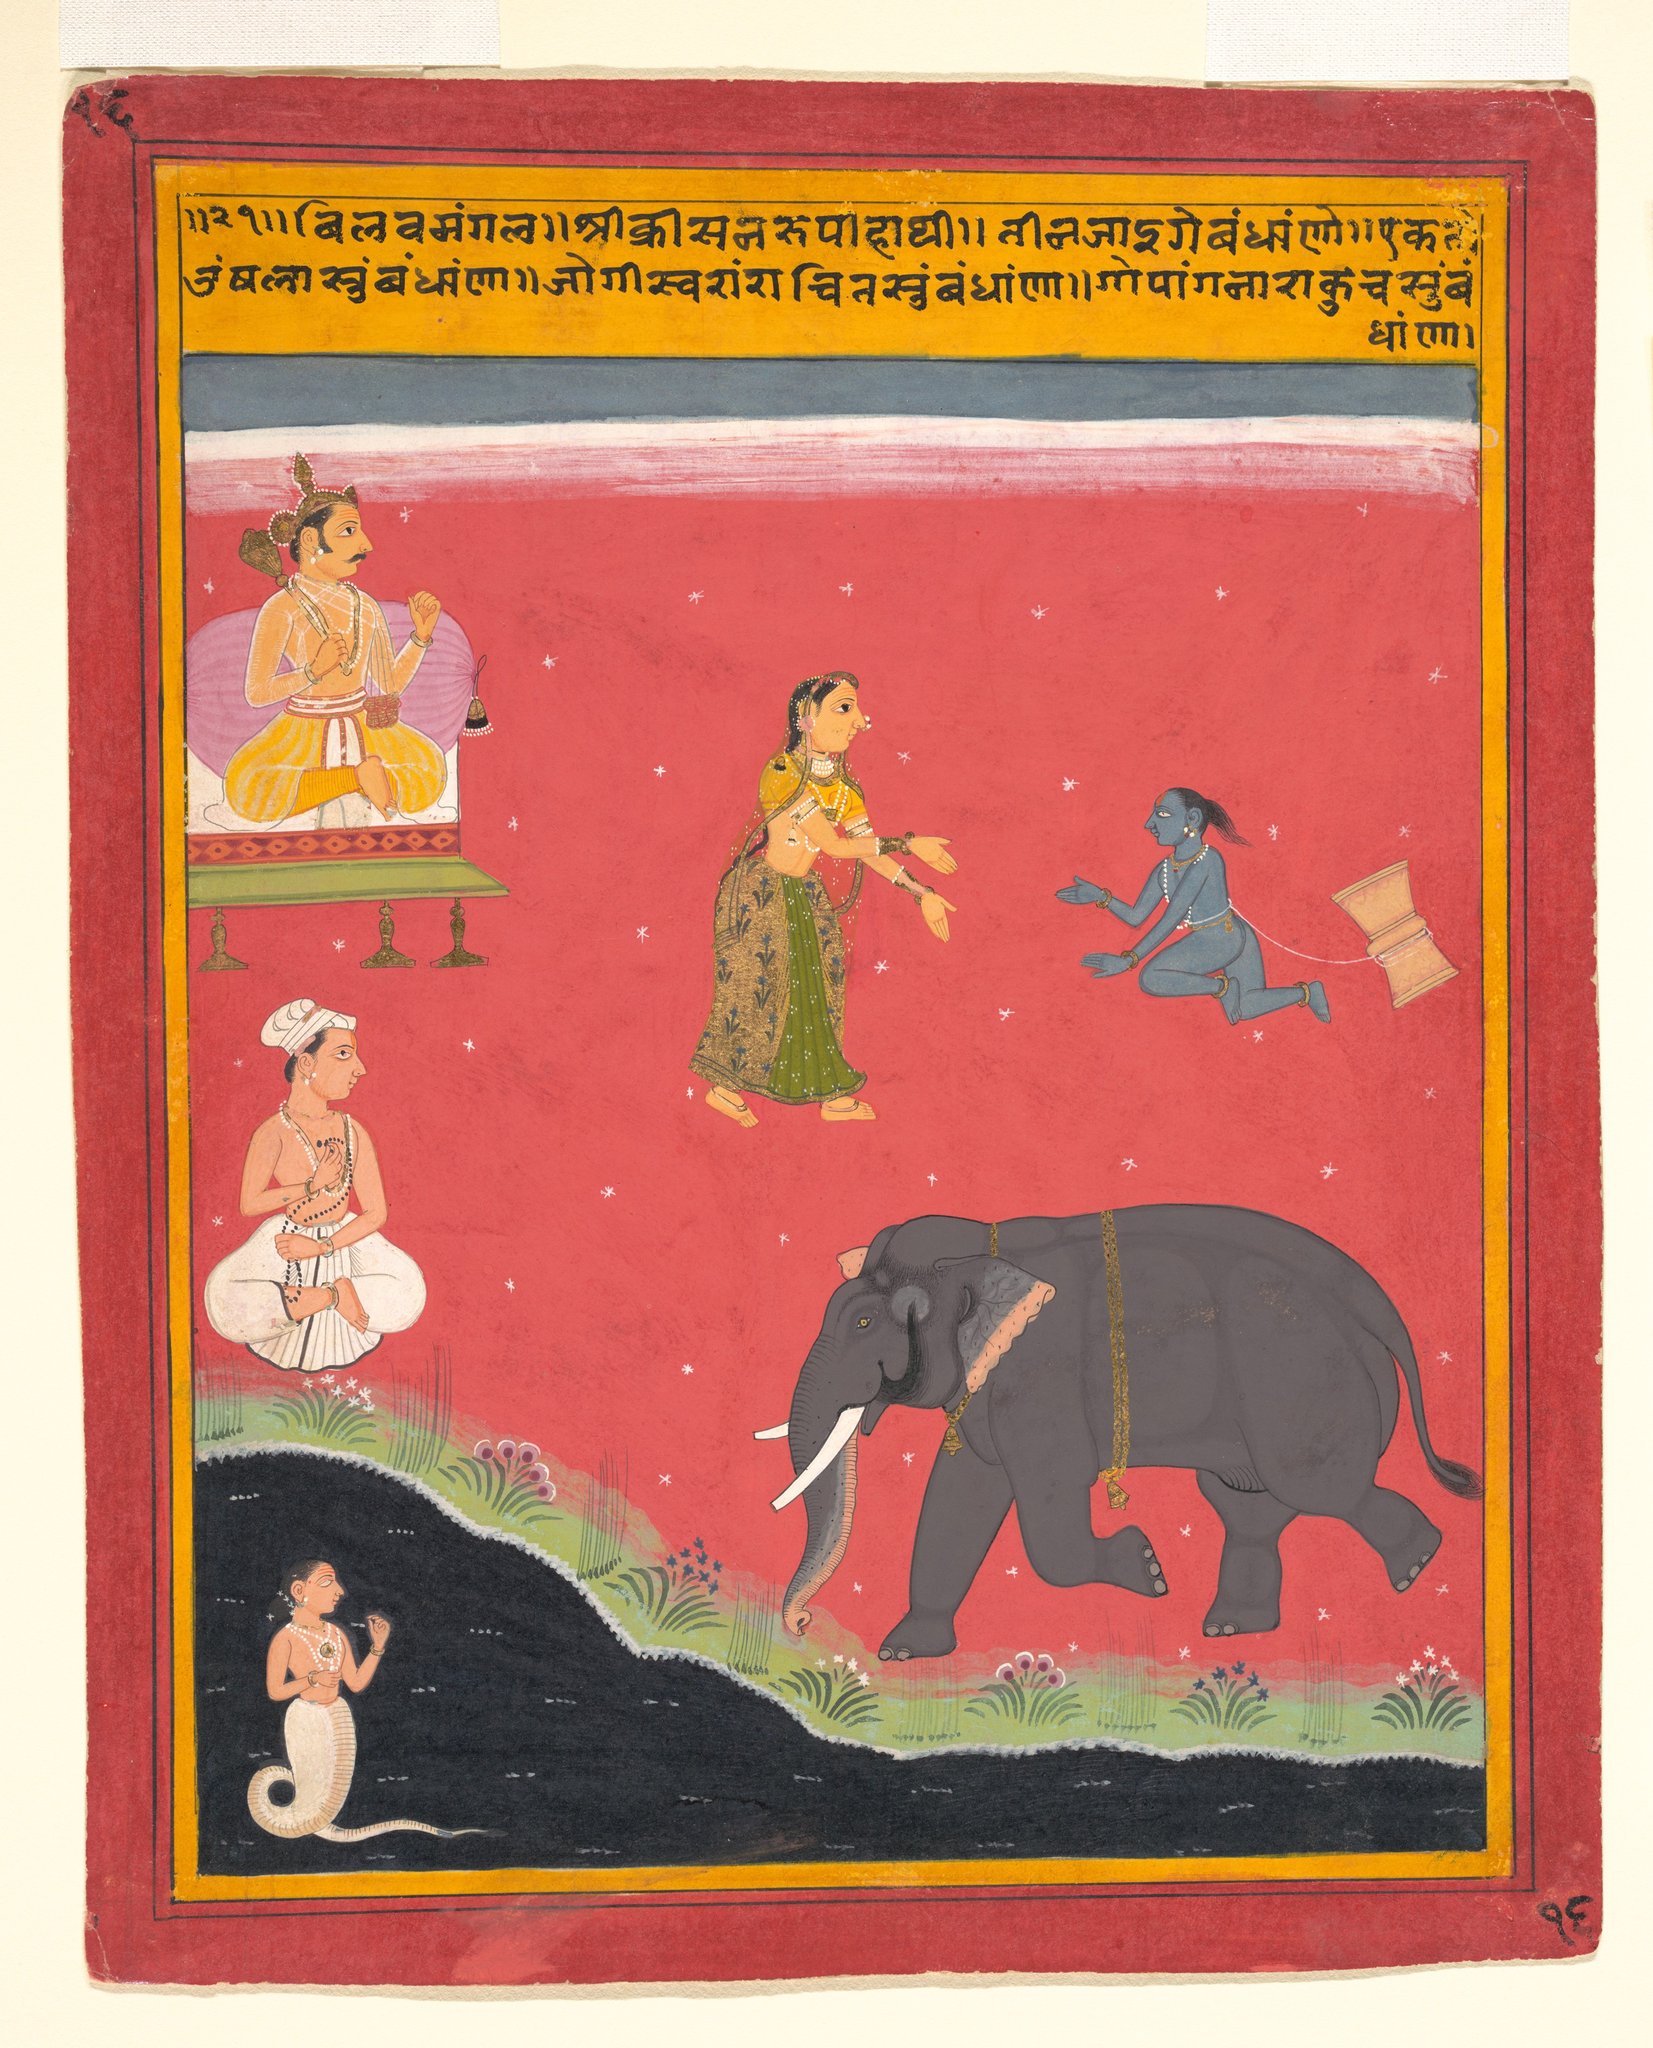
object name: page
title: Krishna's Earthly Ties, Page from a Dispersed Bivamangalastava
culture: mewar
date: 1695-1700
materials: gold, ink, paper, watercolor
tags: men,women,elephants,krishna